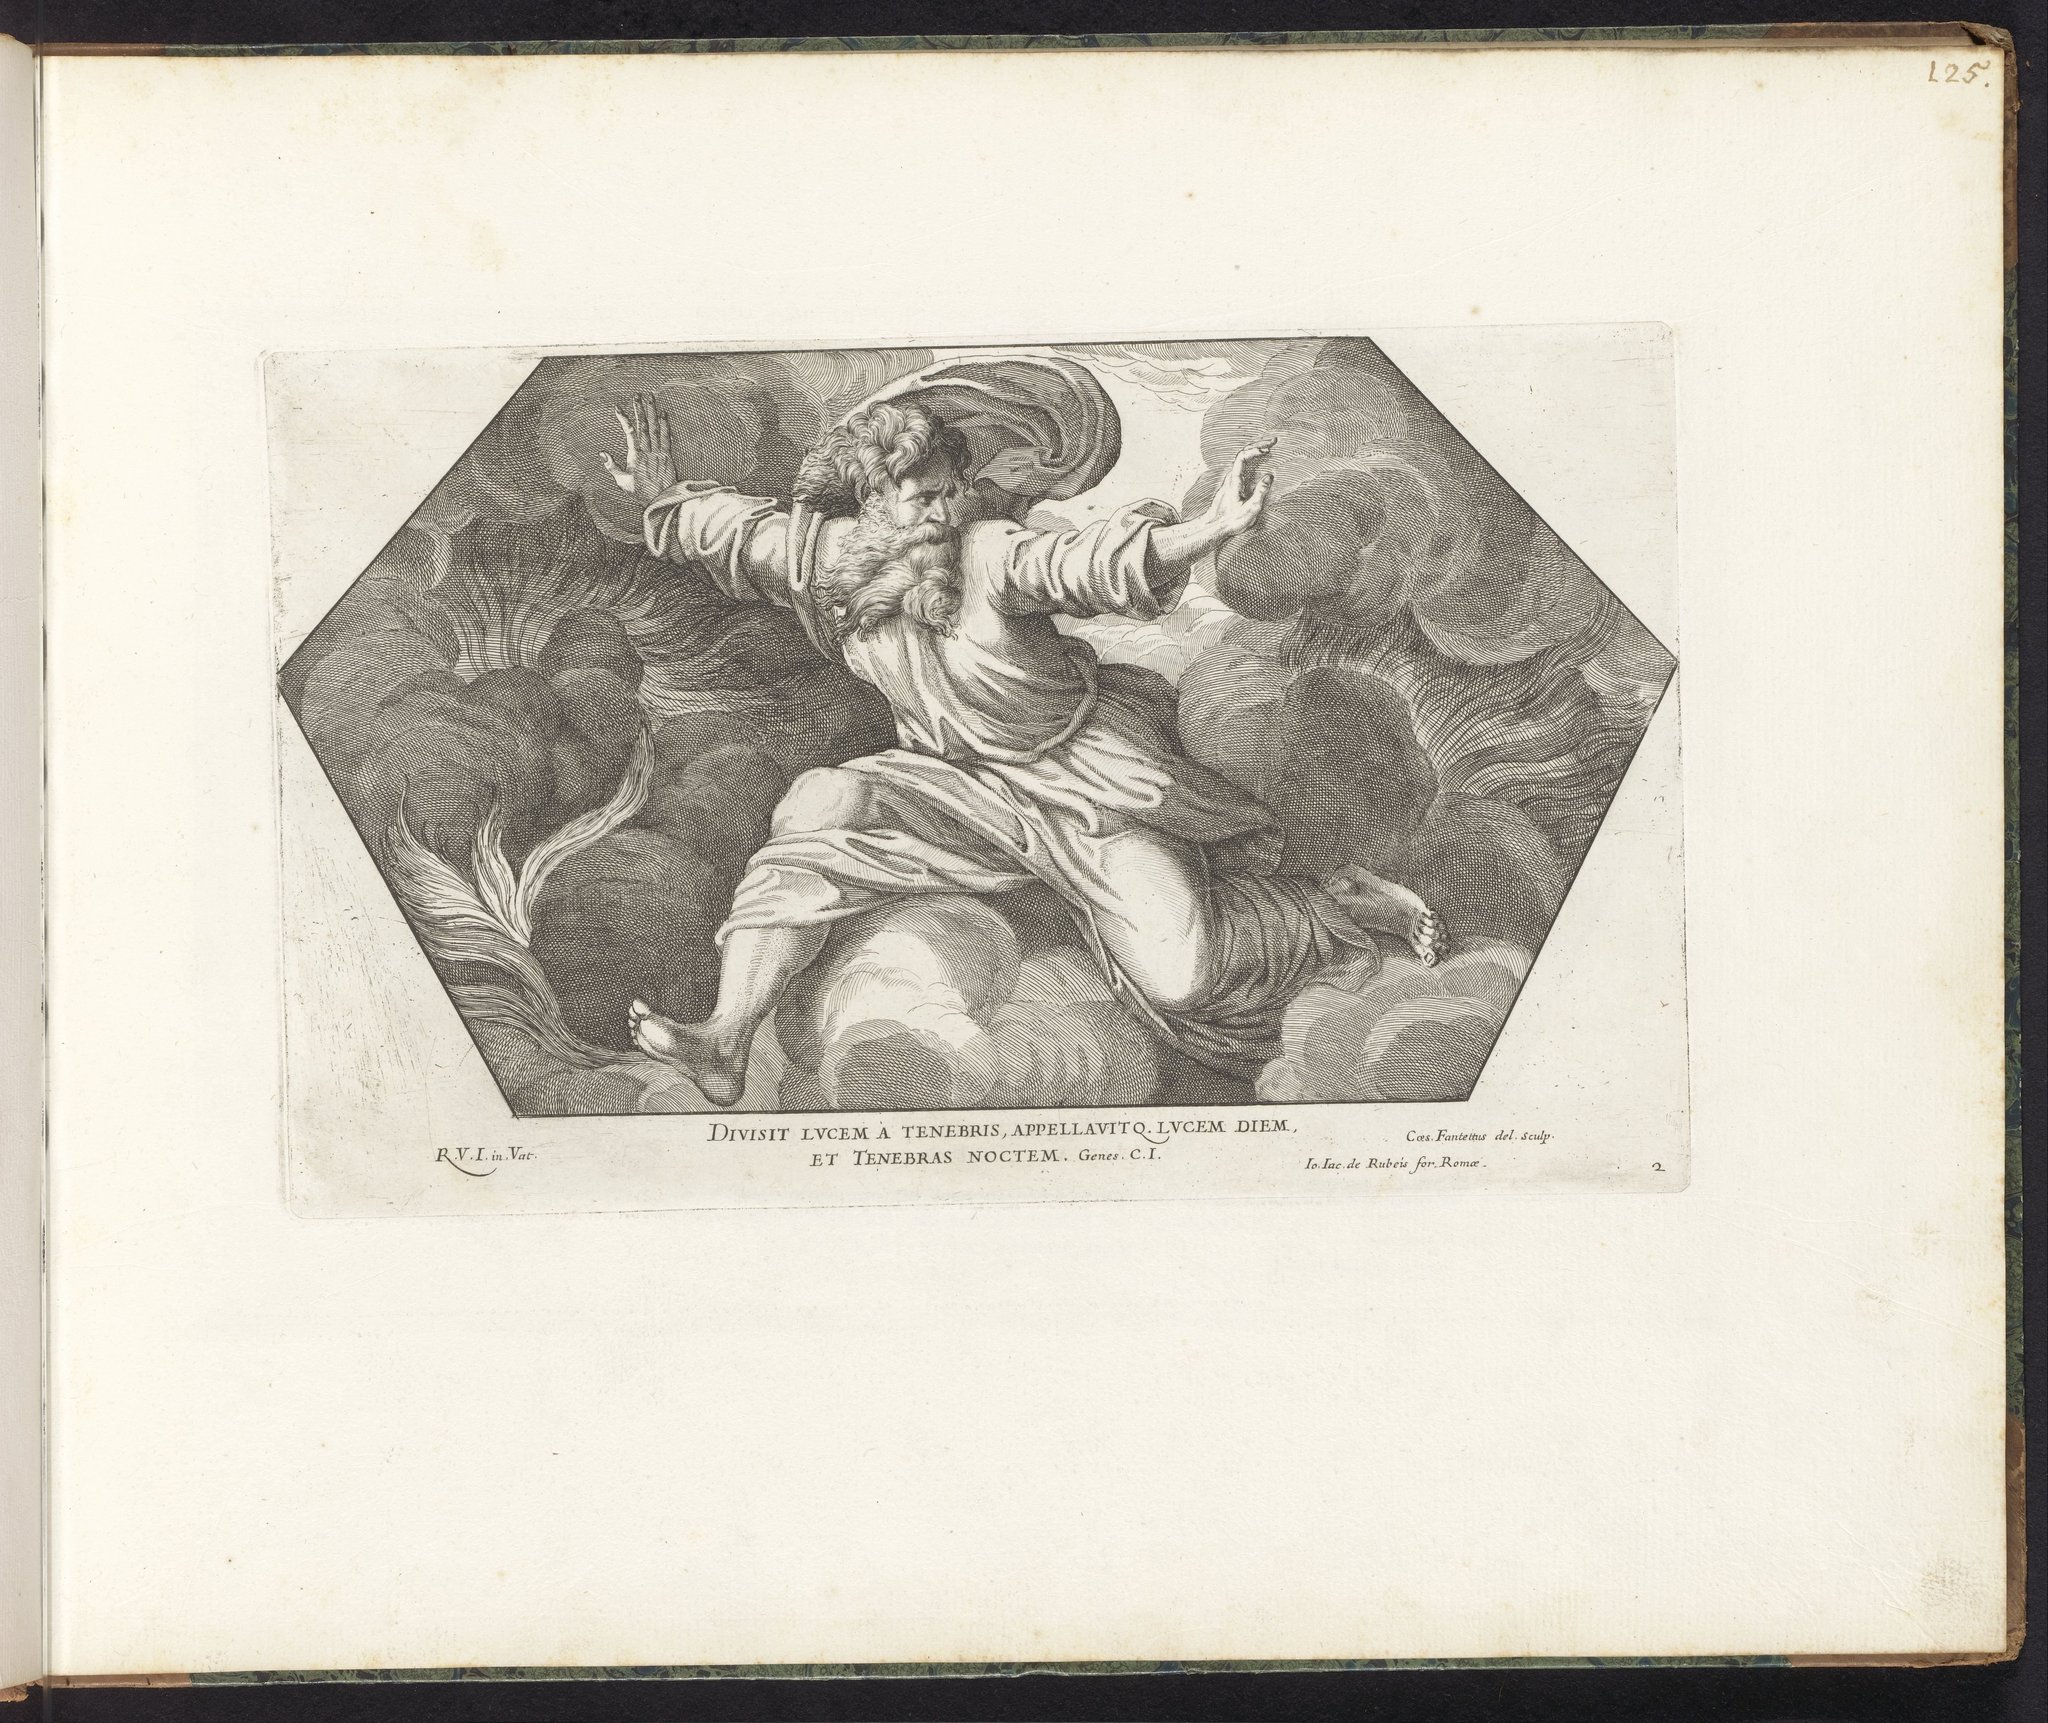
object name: album leaf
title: Rafaël Bijbel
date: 1675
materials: paper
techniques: etching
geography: rome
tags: division of light and darkness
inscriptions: number: ‘125’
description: Prent maakt deel uit van een reeks van 55 prenten, bestaande uit drie ongenummerde prenten en een set van 52 genummerde prenten naar de schilderingen in de Loggia van Rafaël.